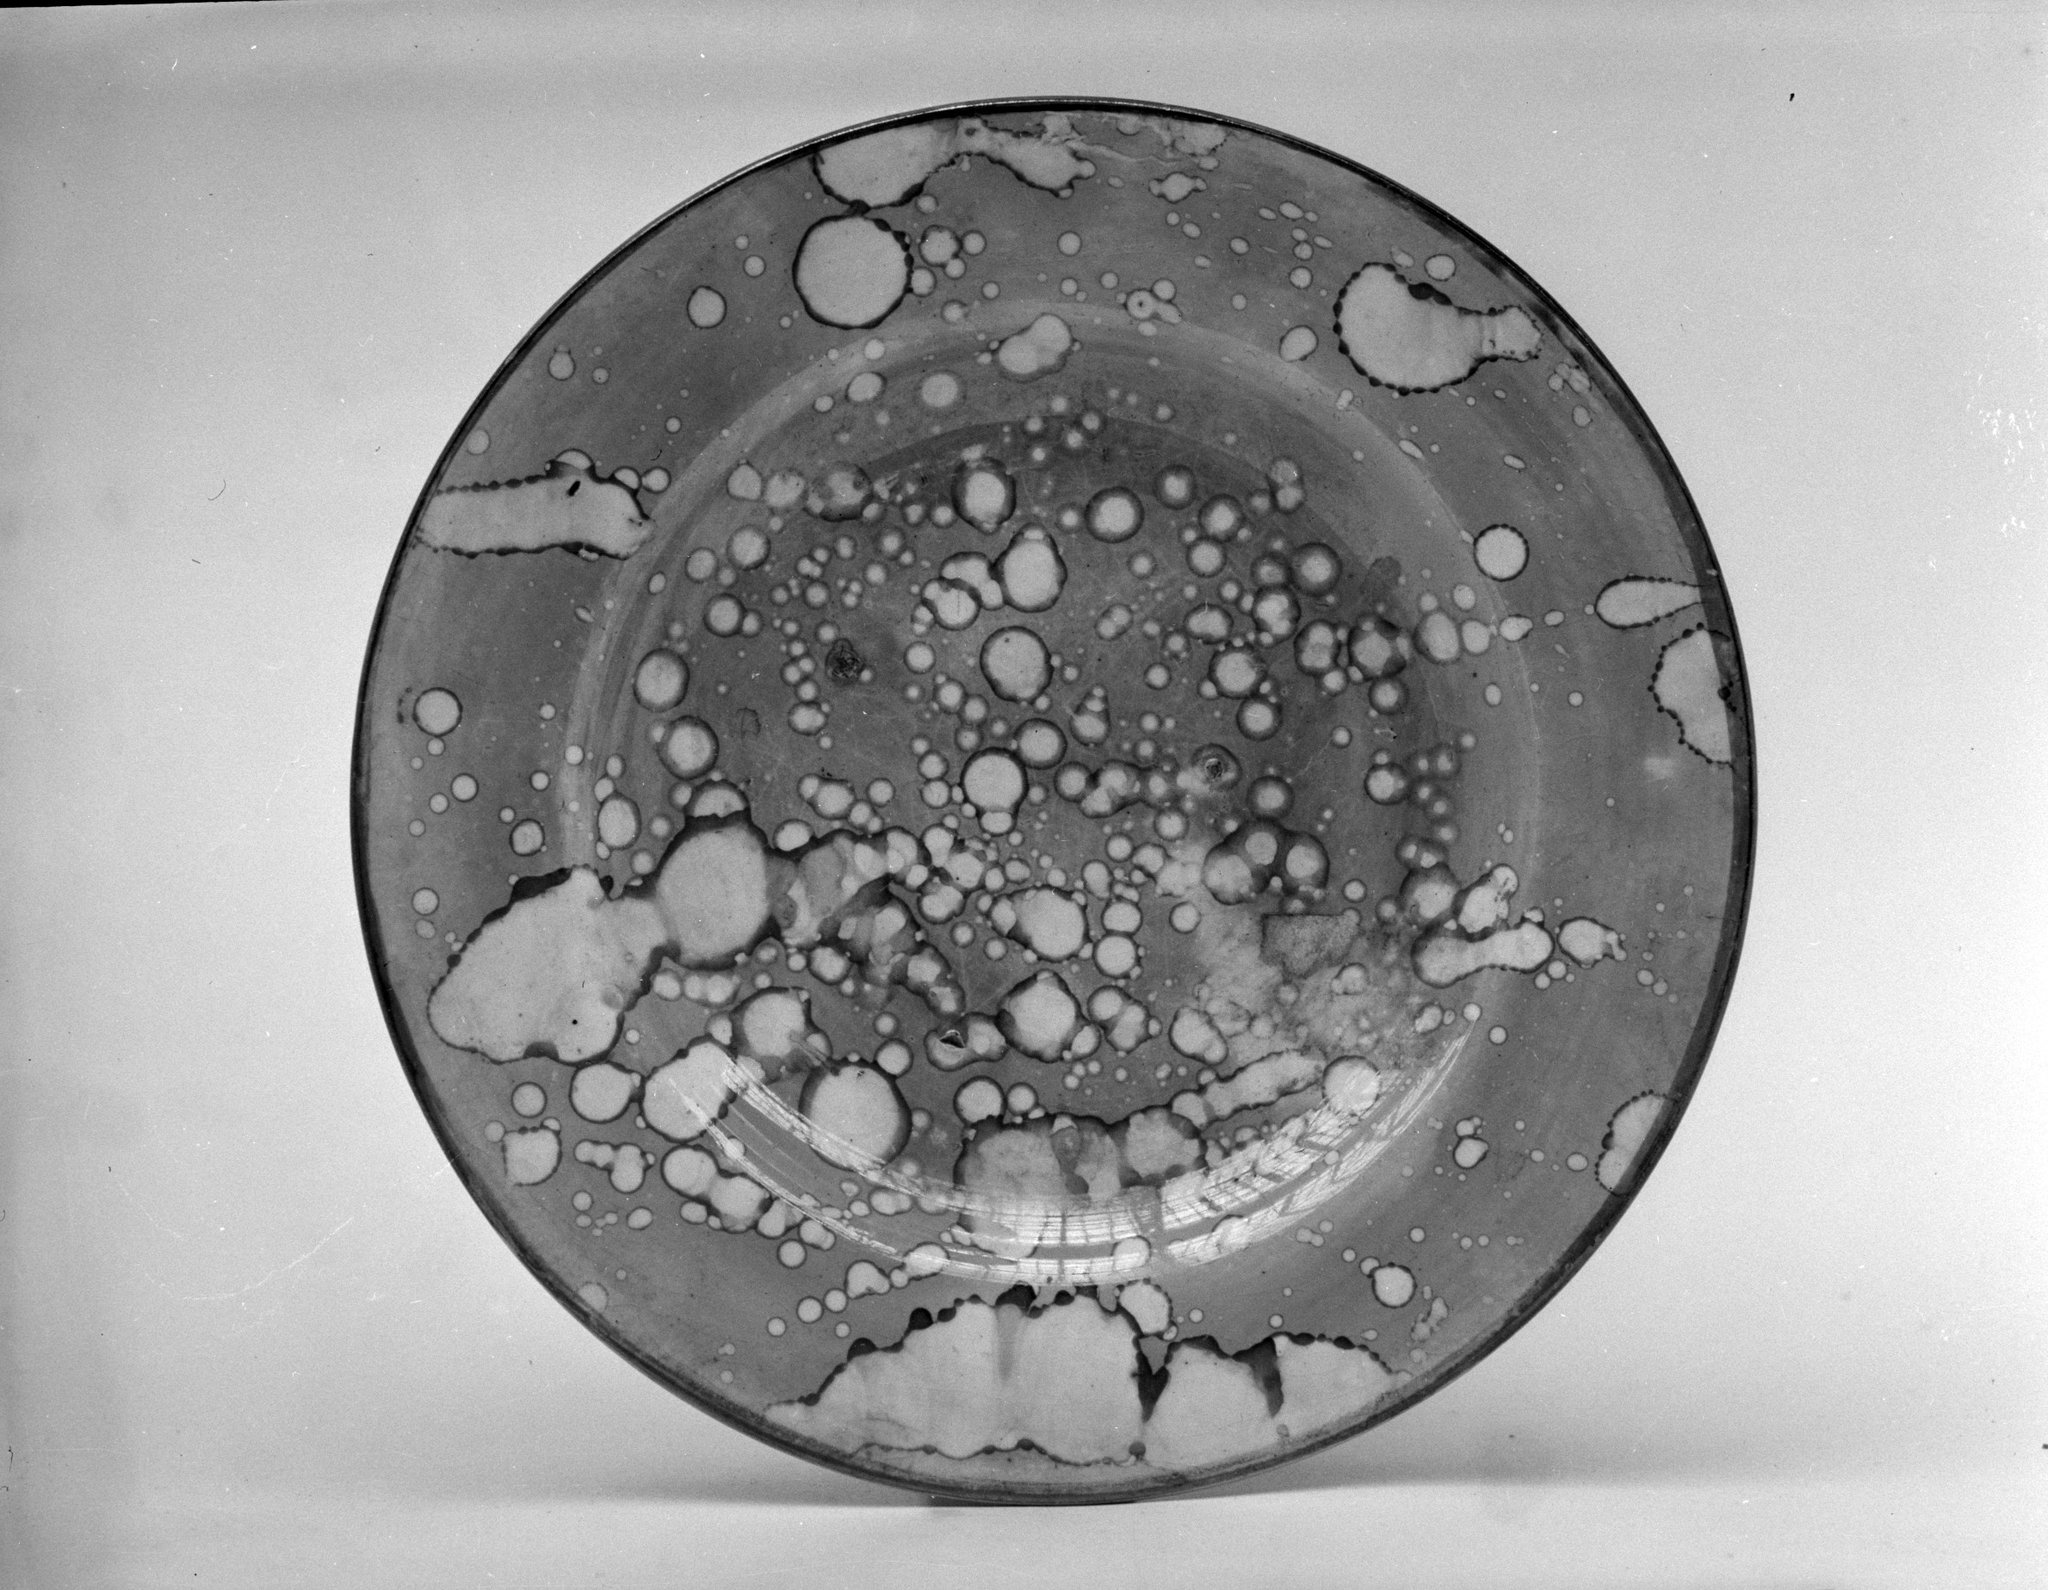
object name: plate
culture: british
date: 1800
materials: earthenware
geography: england